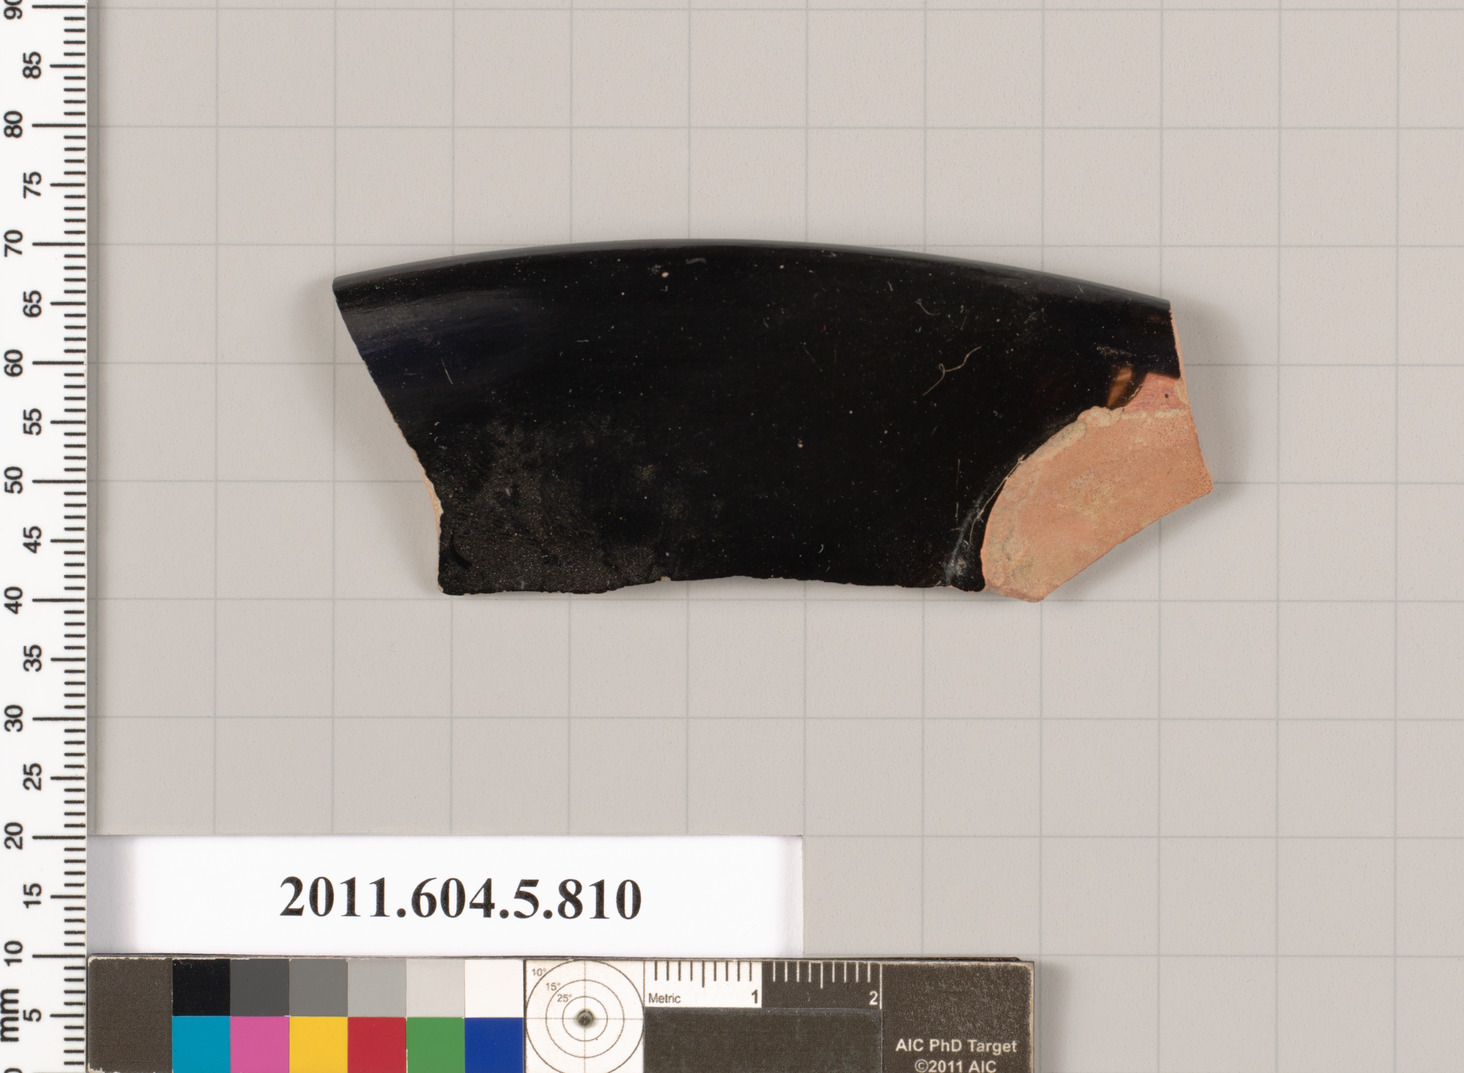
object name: kylix fragment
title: Terracotta rim fragment of a kylix (drinking cup)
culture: greek, attic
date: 600-401 BCE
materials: terracotta